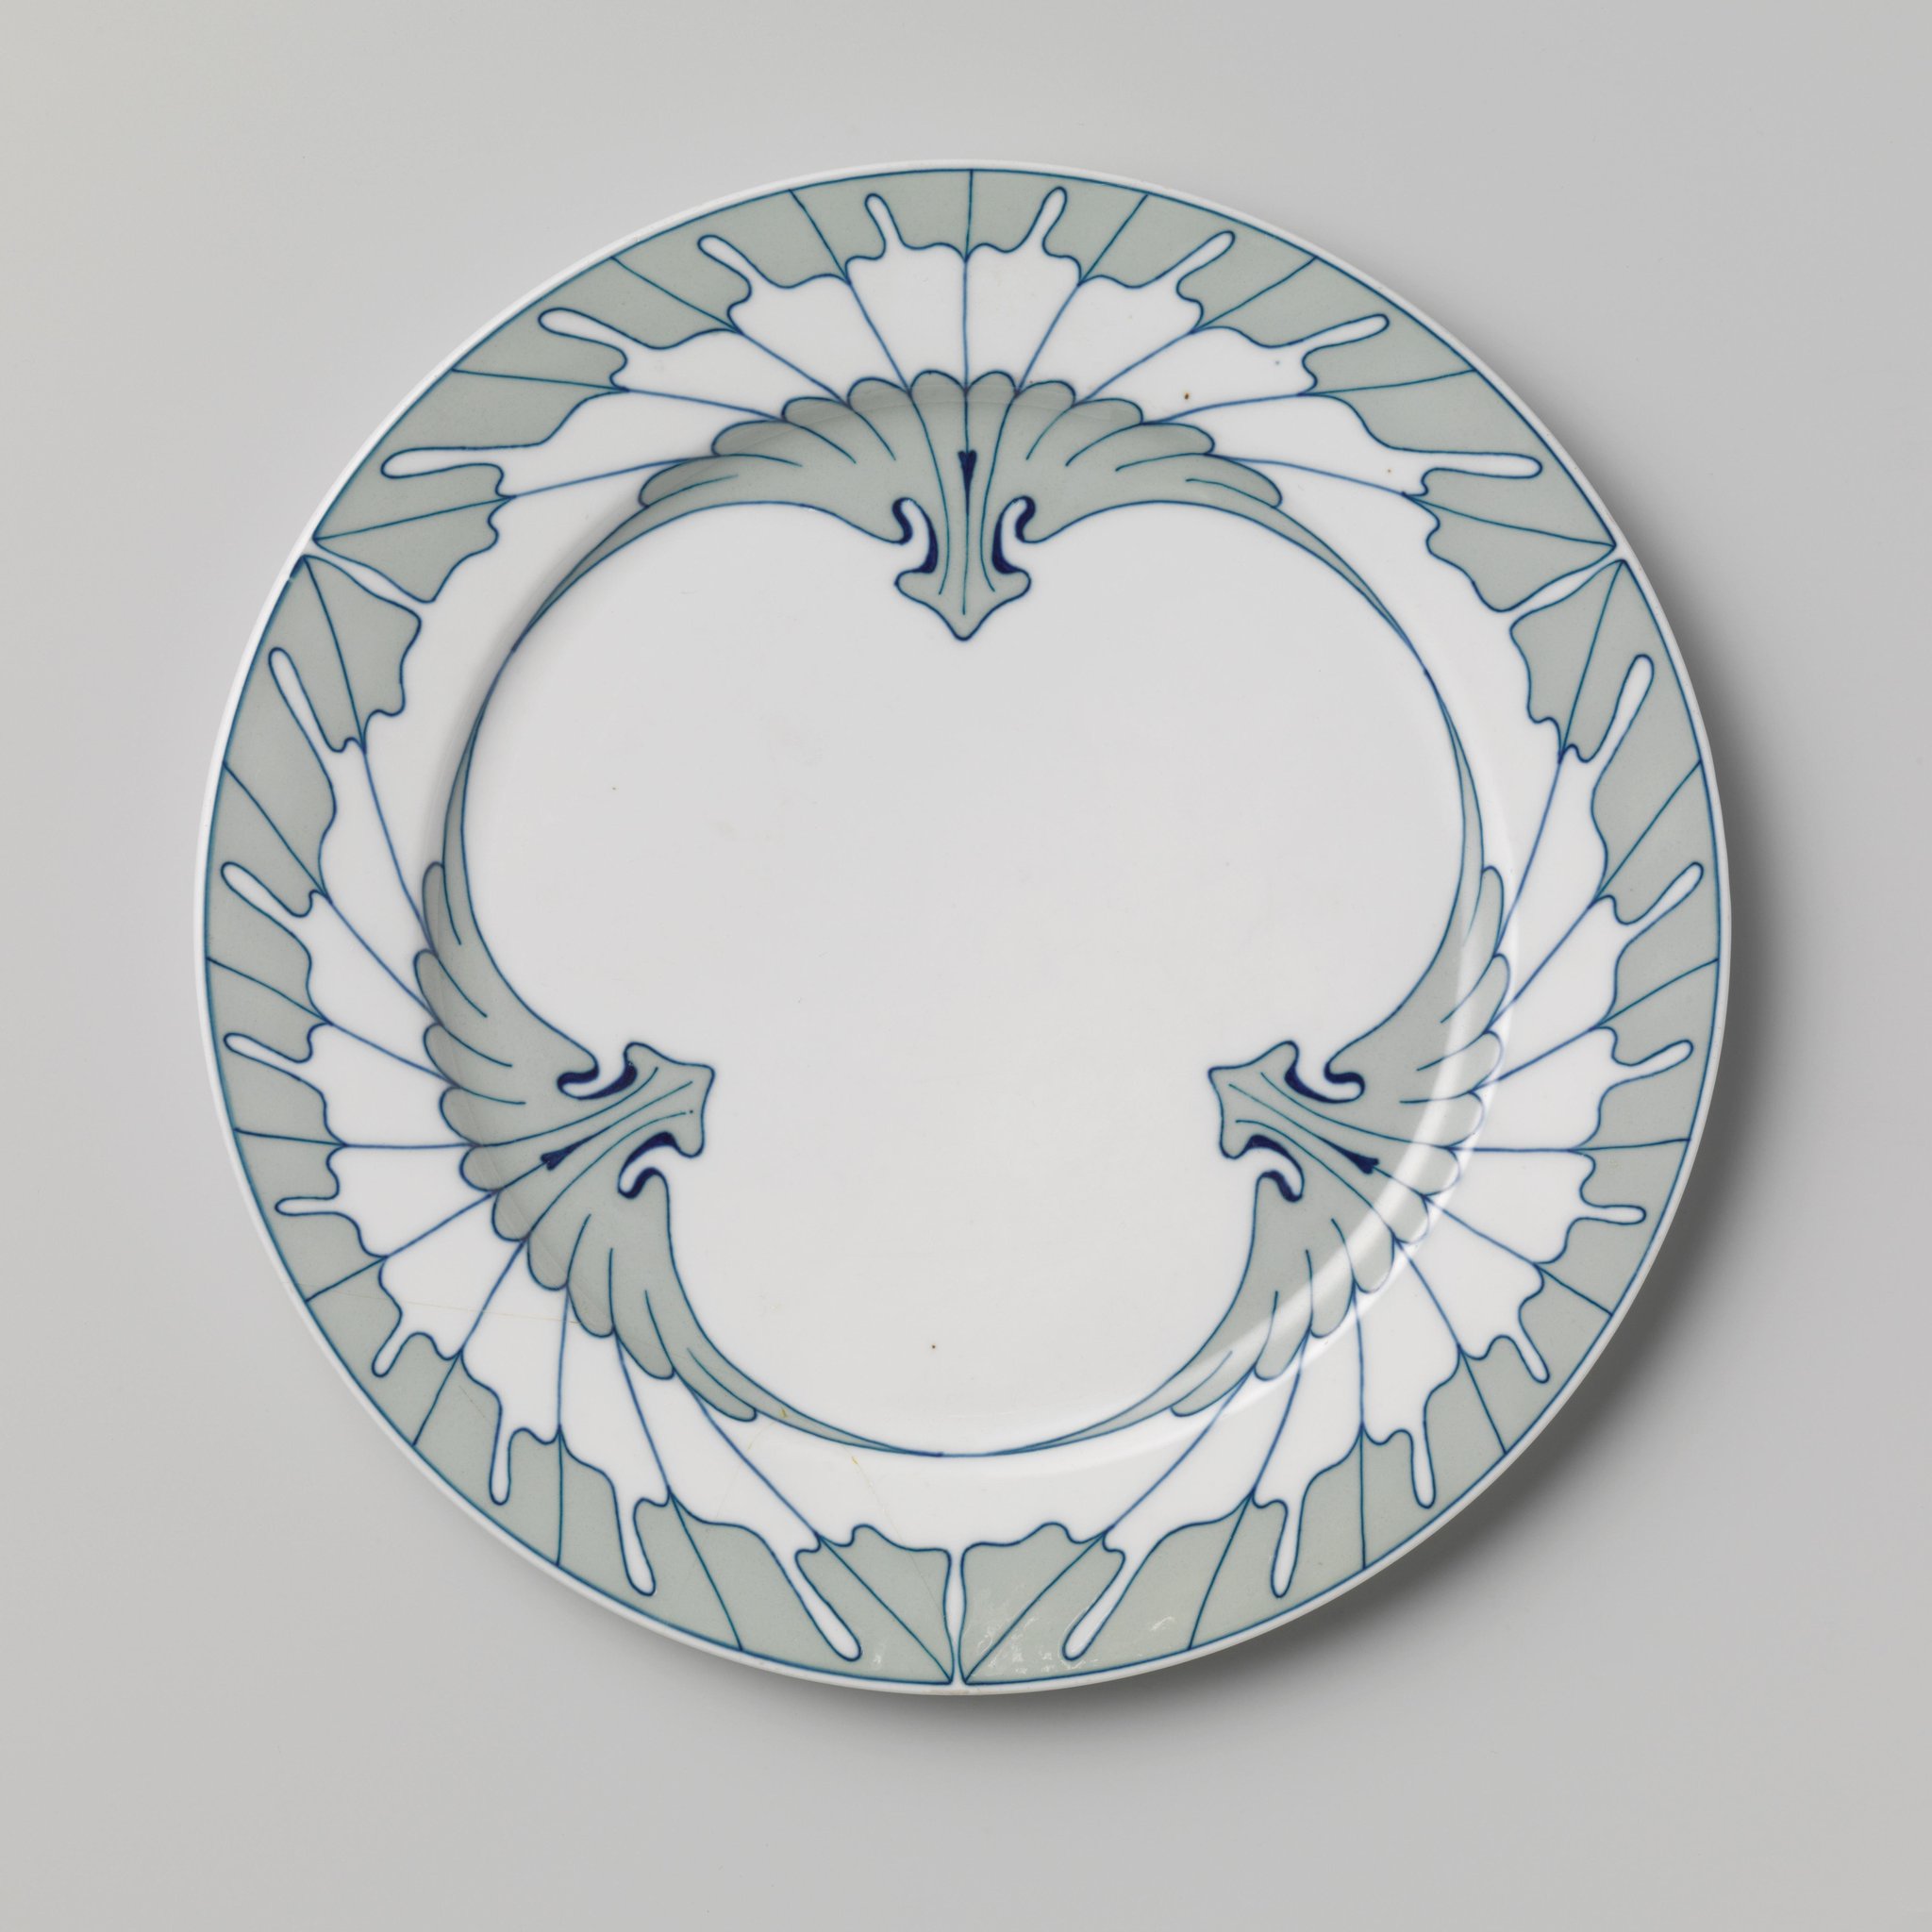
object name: eating drinking utensil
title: Bord, beschilderd met het Flügelmuster-decor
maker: konrad hentschel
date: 1901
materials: porcelain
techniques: painted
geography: meissen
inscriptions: factory mark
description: Bord van beschilderd porselein. Het bord is beschilderd in groen en blauw met het Flügelmuster. Het bord hoort bij een servies (BK-1976-65-1 t/m BK-1976-65-34) en is gemerkt.